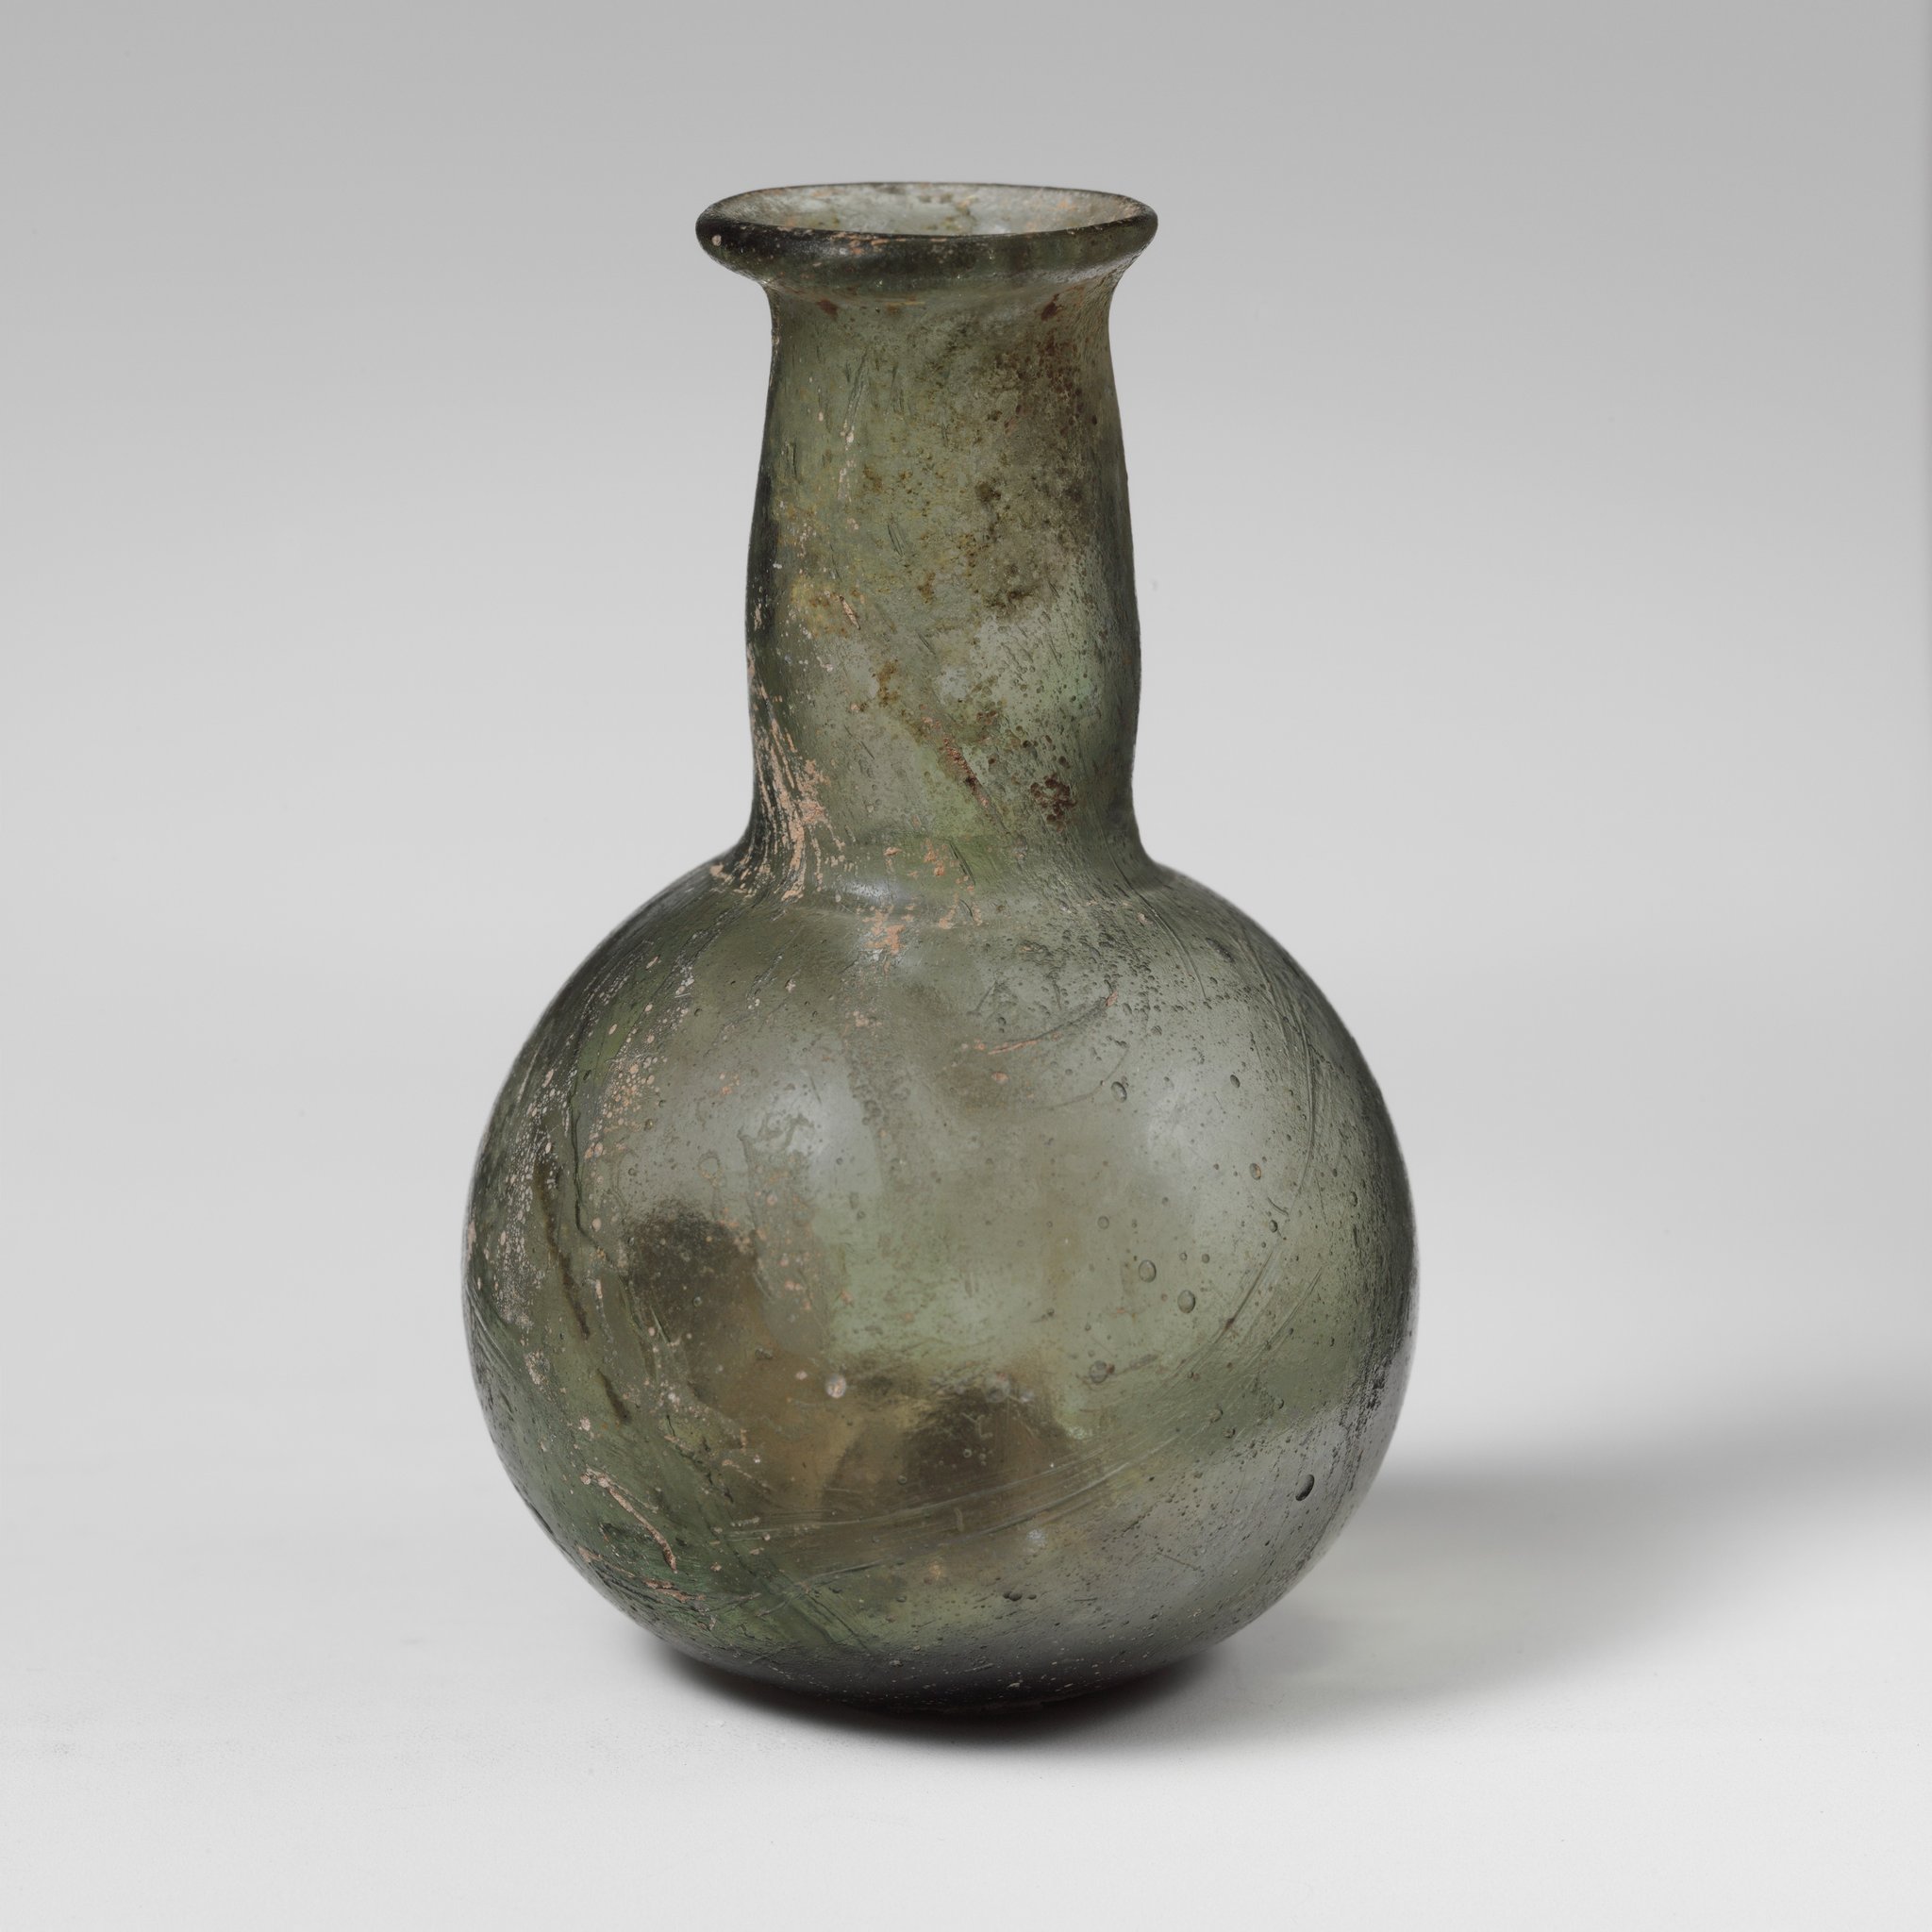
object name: perfume bottle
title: Glass perfume bottle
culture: roman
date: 1-100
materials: glass